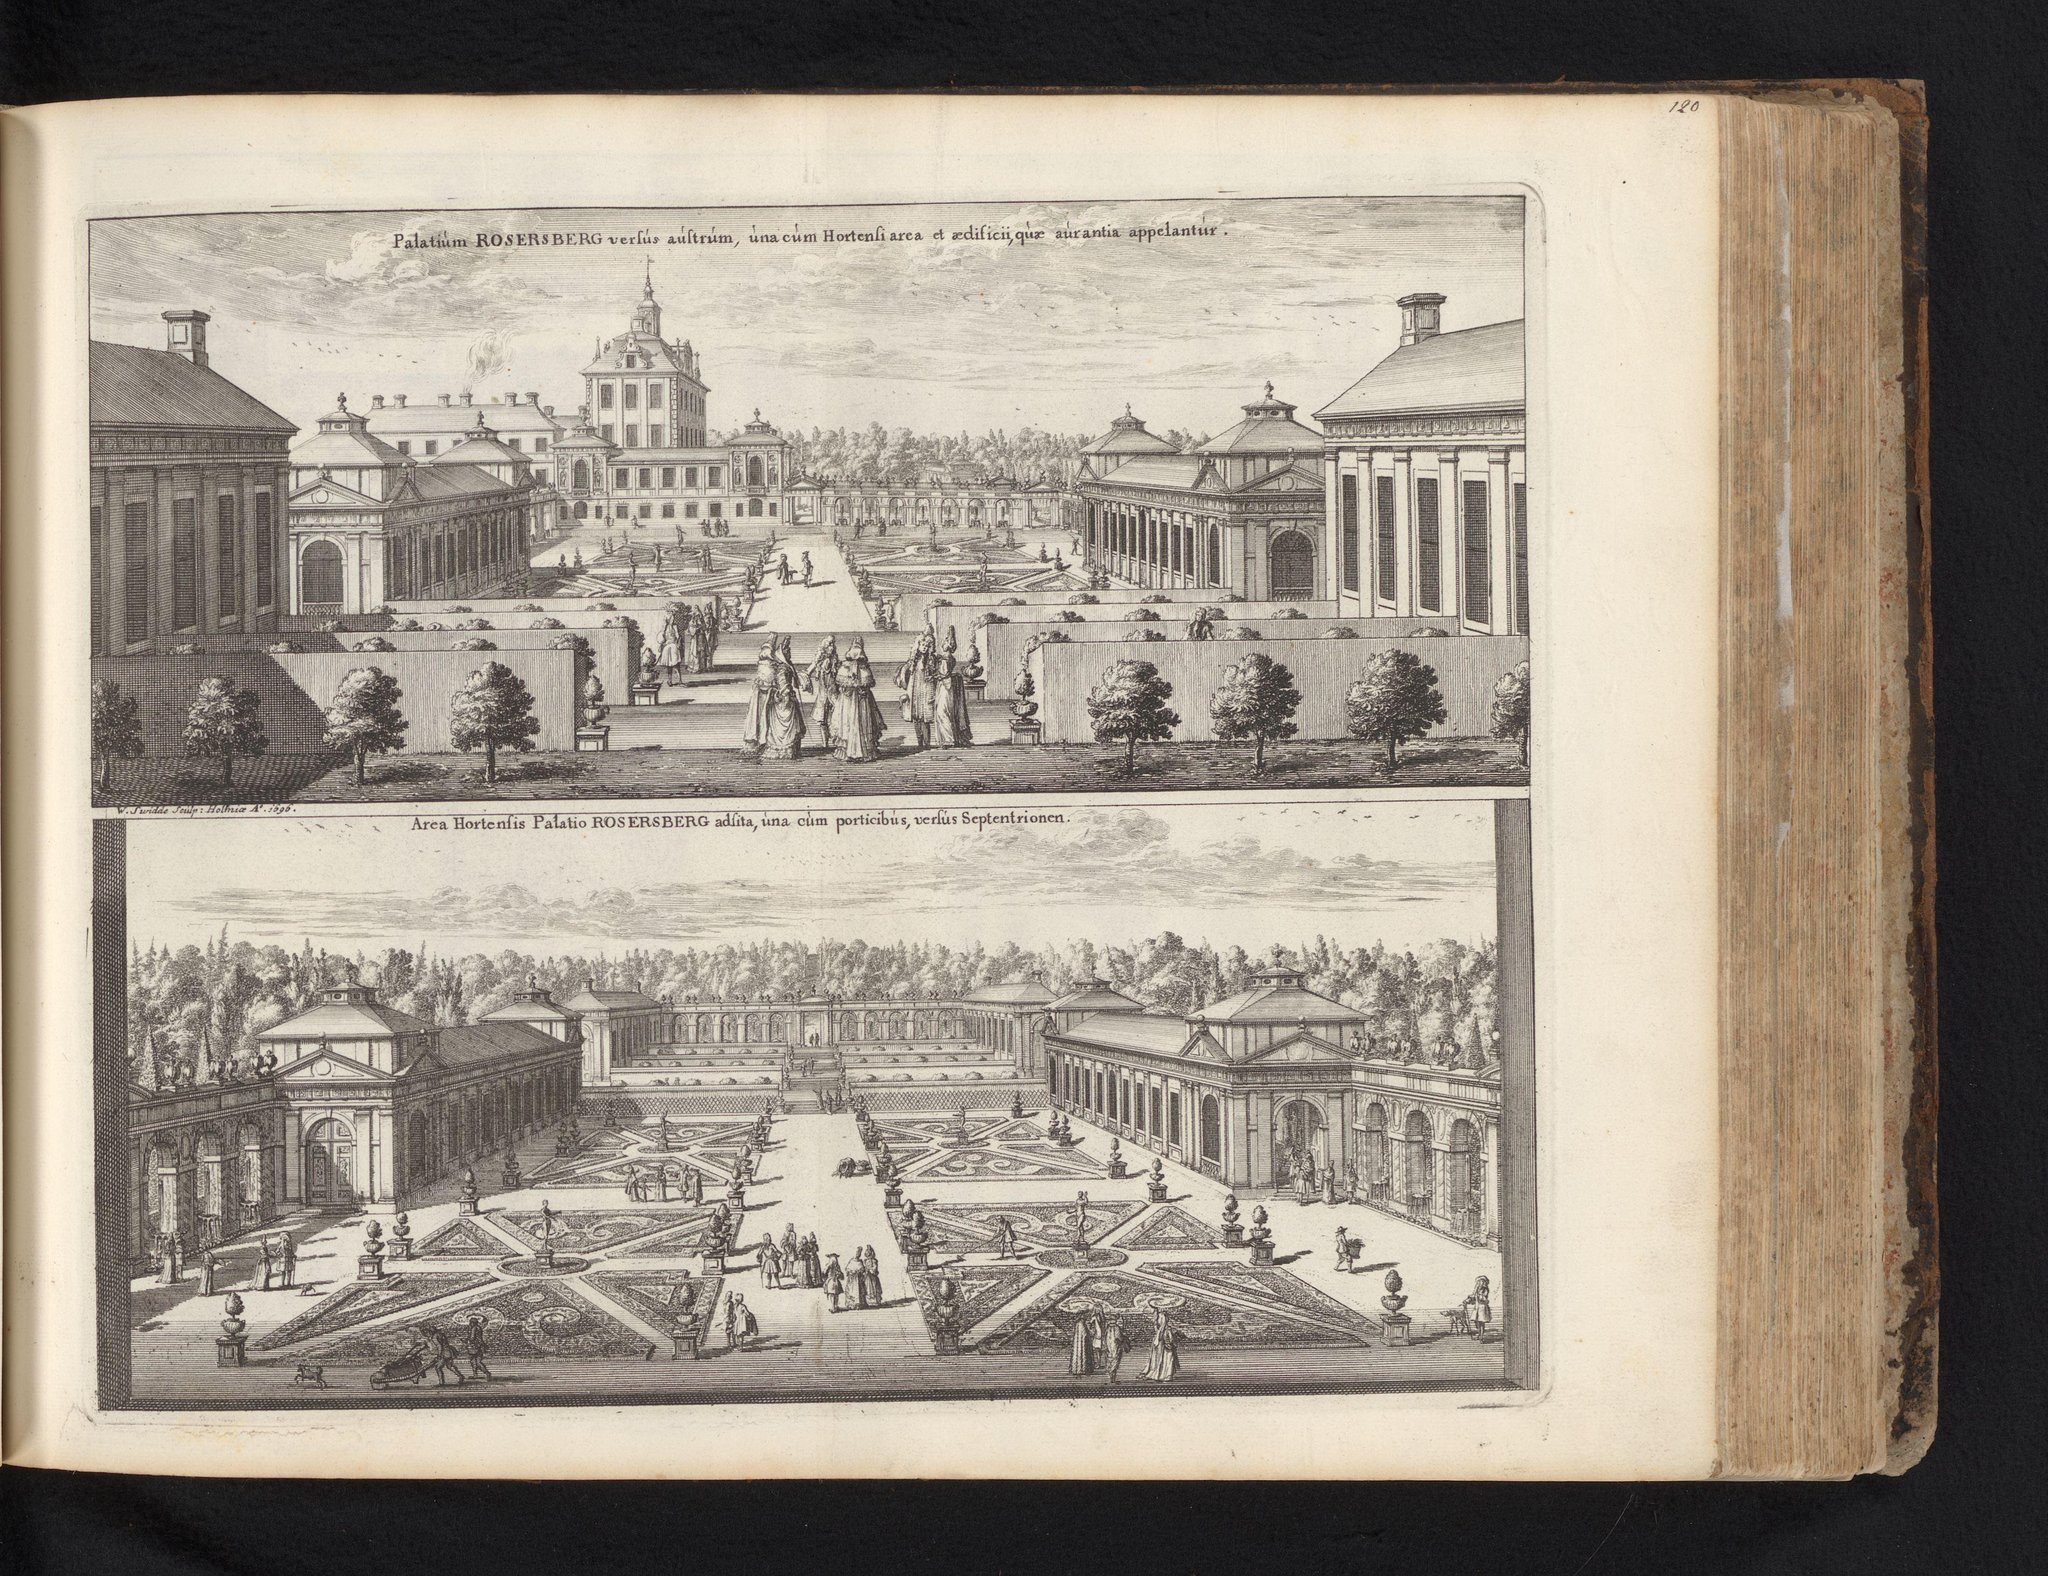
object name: print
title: Palatium Rosersberg versus austrum, una cum Hortensi area et aedificii, quae aurantia appelantur / Area Hortensis Palatio Rosersberg adsita, una cum porticibus, versus Septentrionem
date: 1696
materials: paper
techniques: etching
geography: stockholm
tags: garden, housing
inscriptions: date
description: Kungliga Biblioteket, 'Suecia': http://www.kb.se/samlingarna/Kartor-bilder/Suecia-antiqua/ (geraadpleegd november 2016).